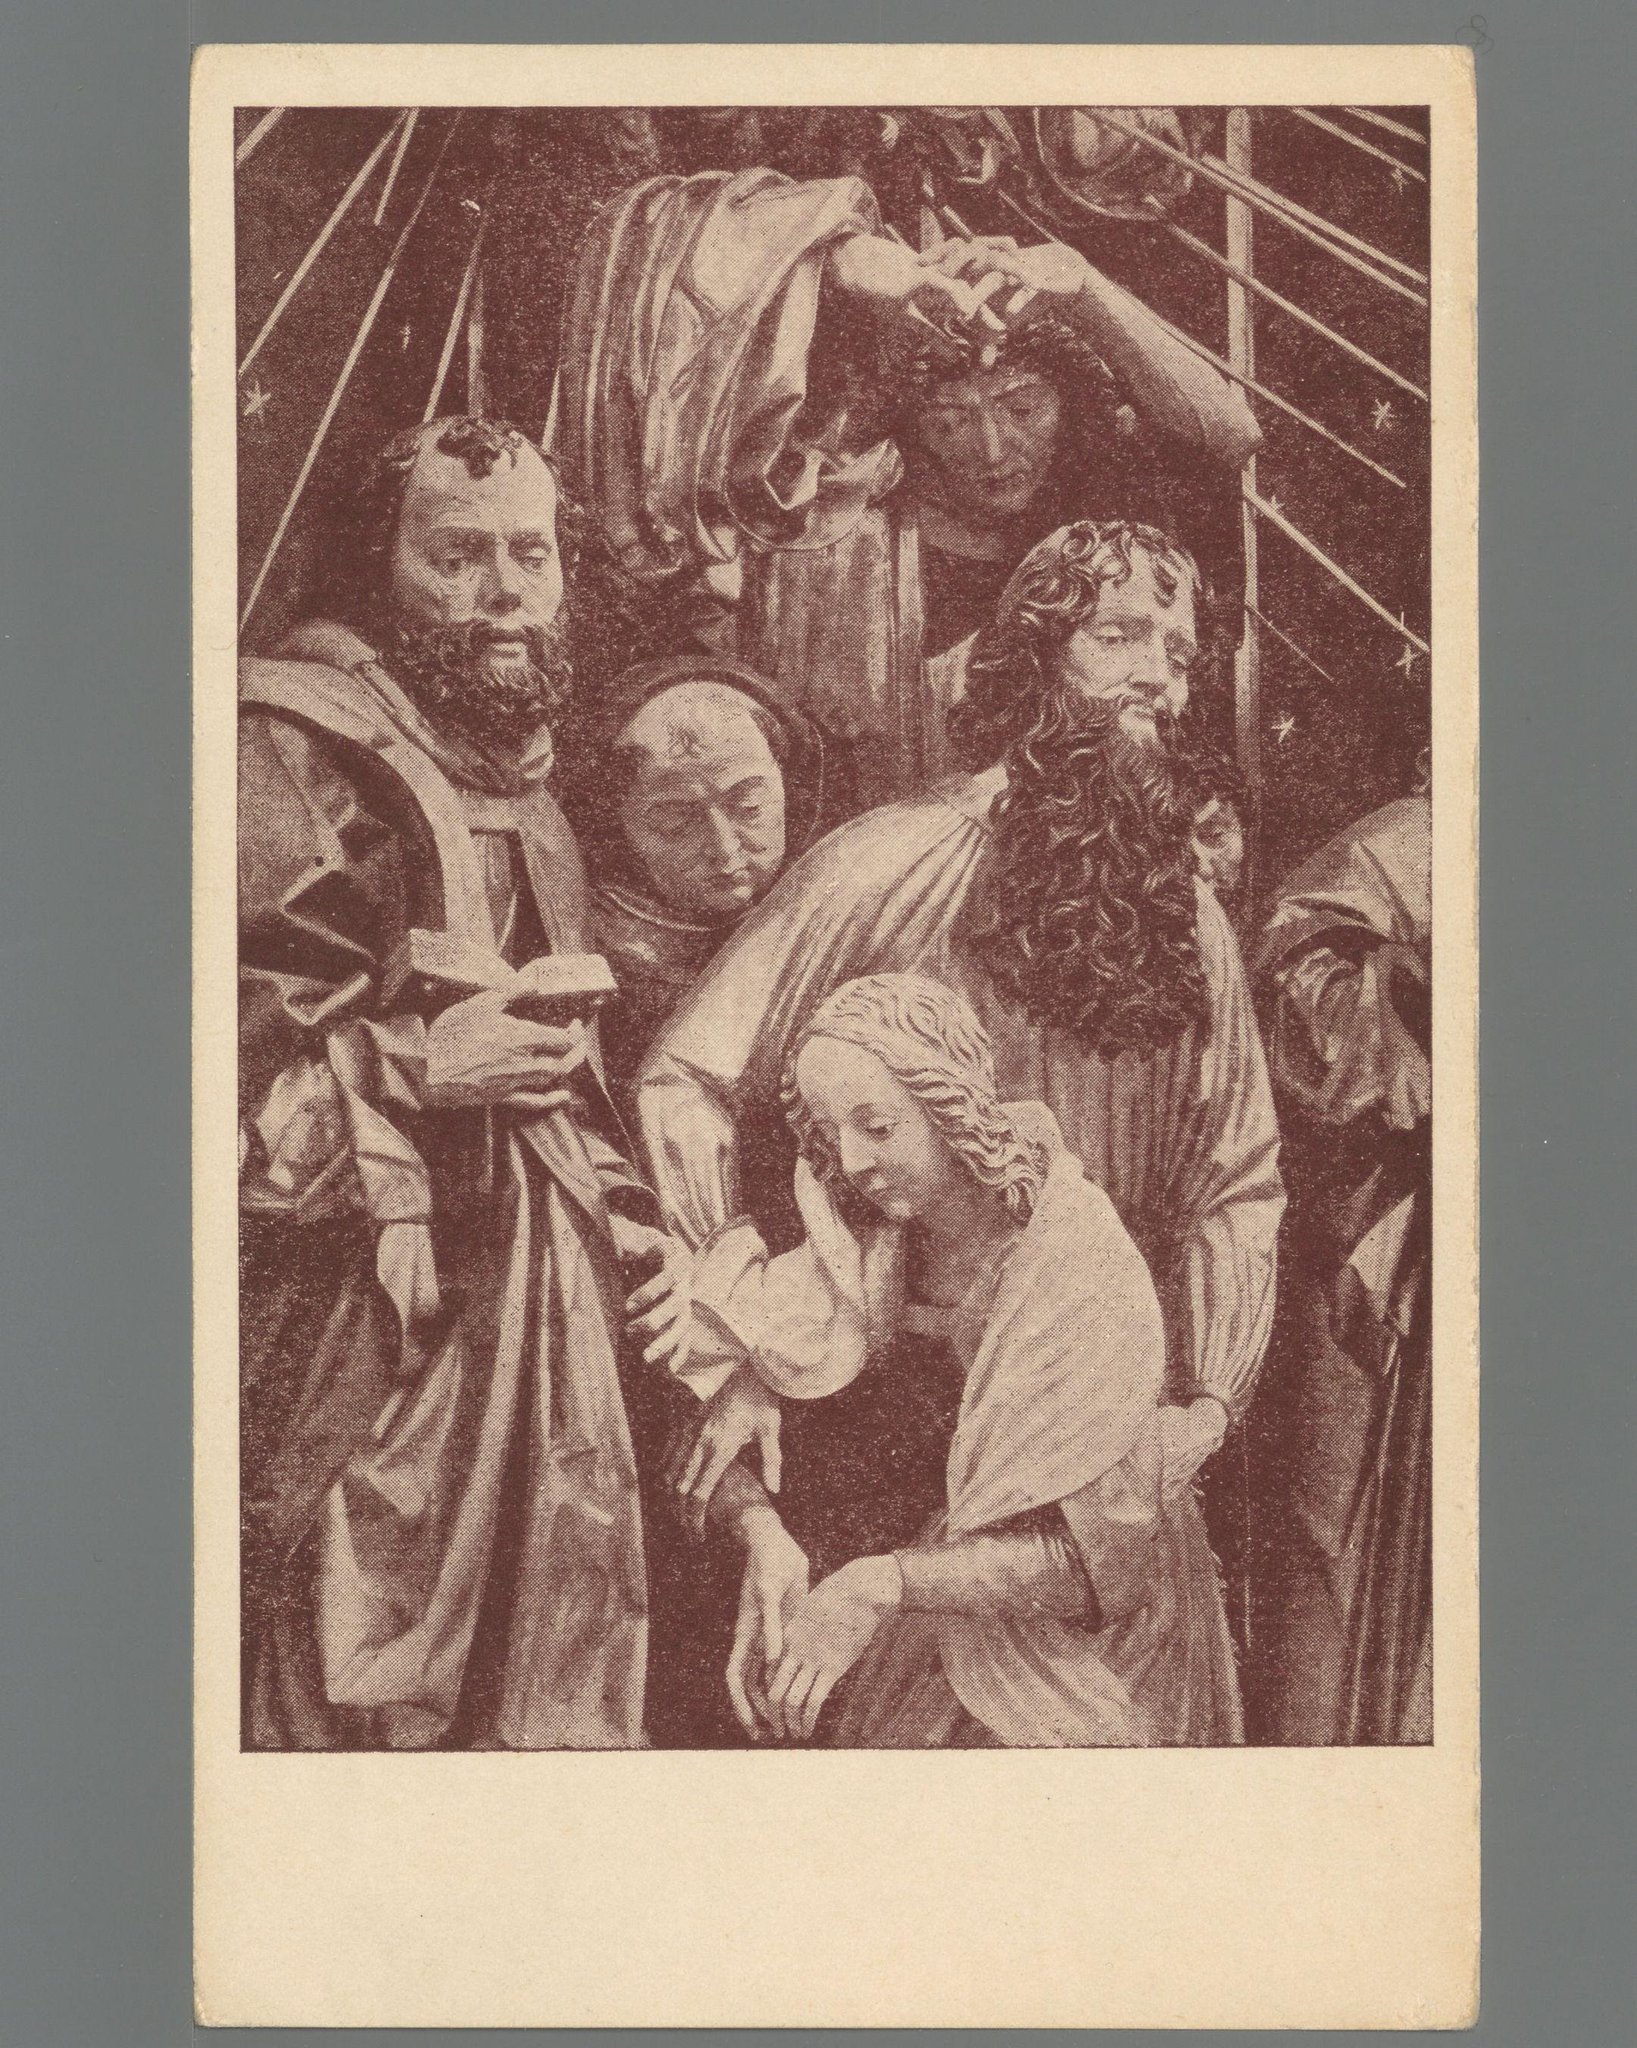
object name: ansichtkaart, prentbriefkaart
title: Grupa z Zasniecia Matki Najsw. na ołtarzu Wita Stwosza w kosciele najsw. Marii Panny w Krakowie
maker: Anonymous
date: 1920-1960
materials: cardboard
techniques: autotype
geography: krakow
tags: interior of church, sculpture, altar with altar-piece